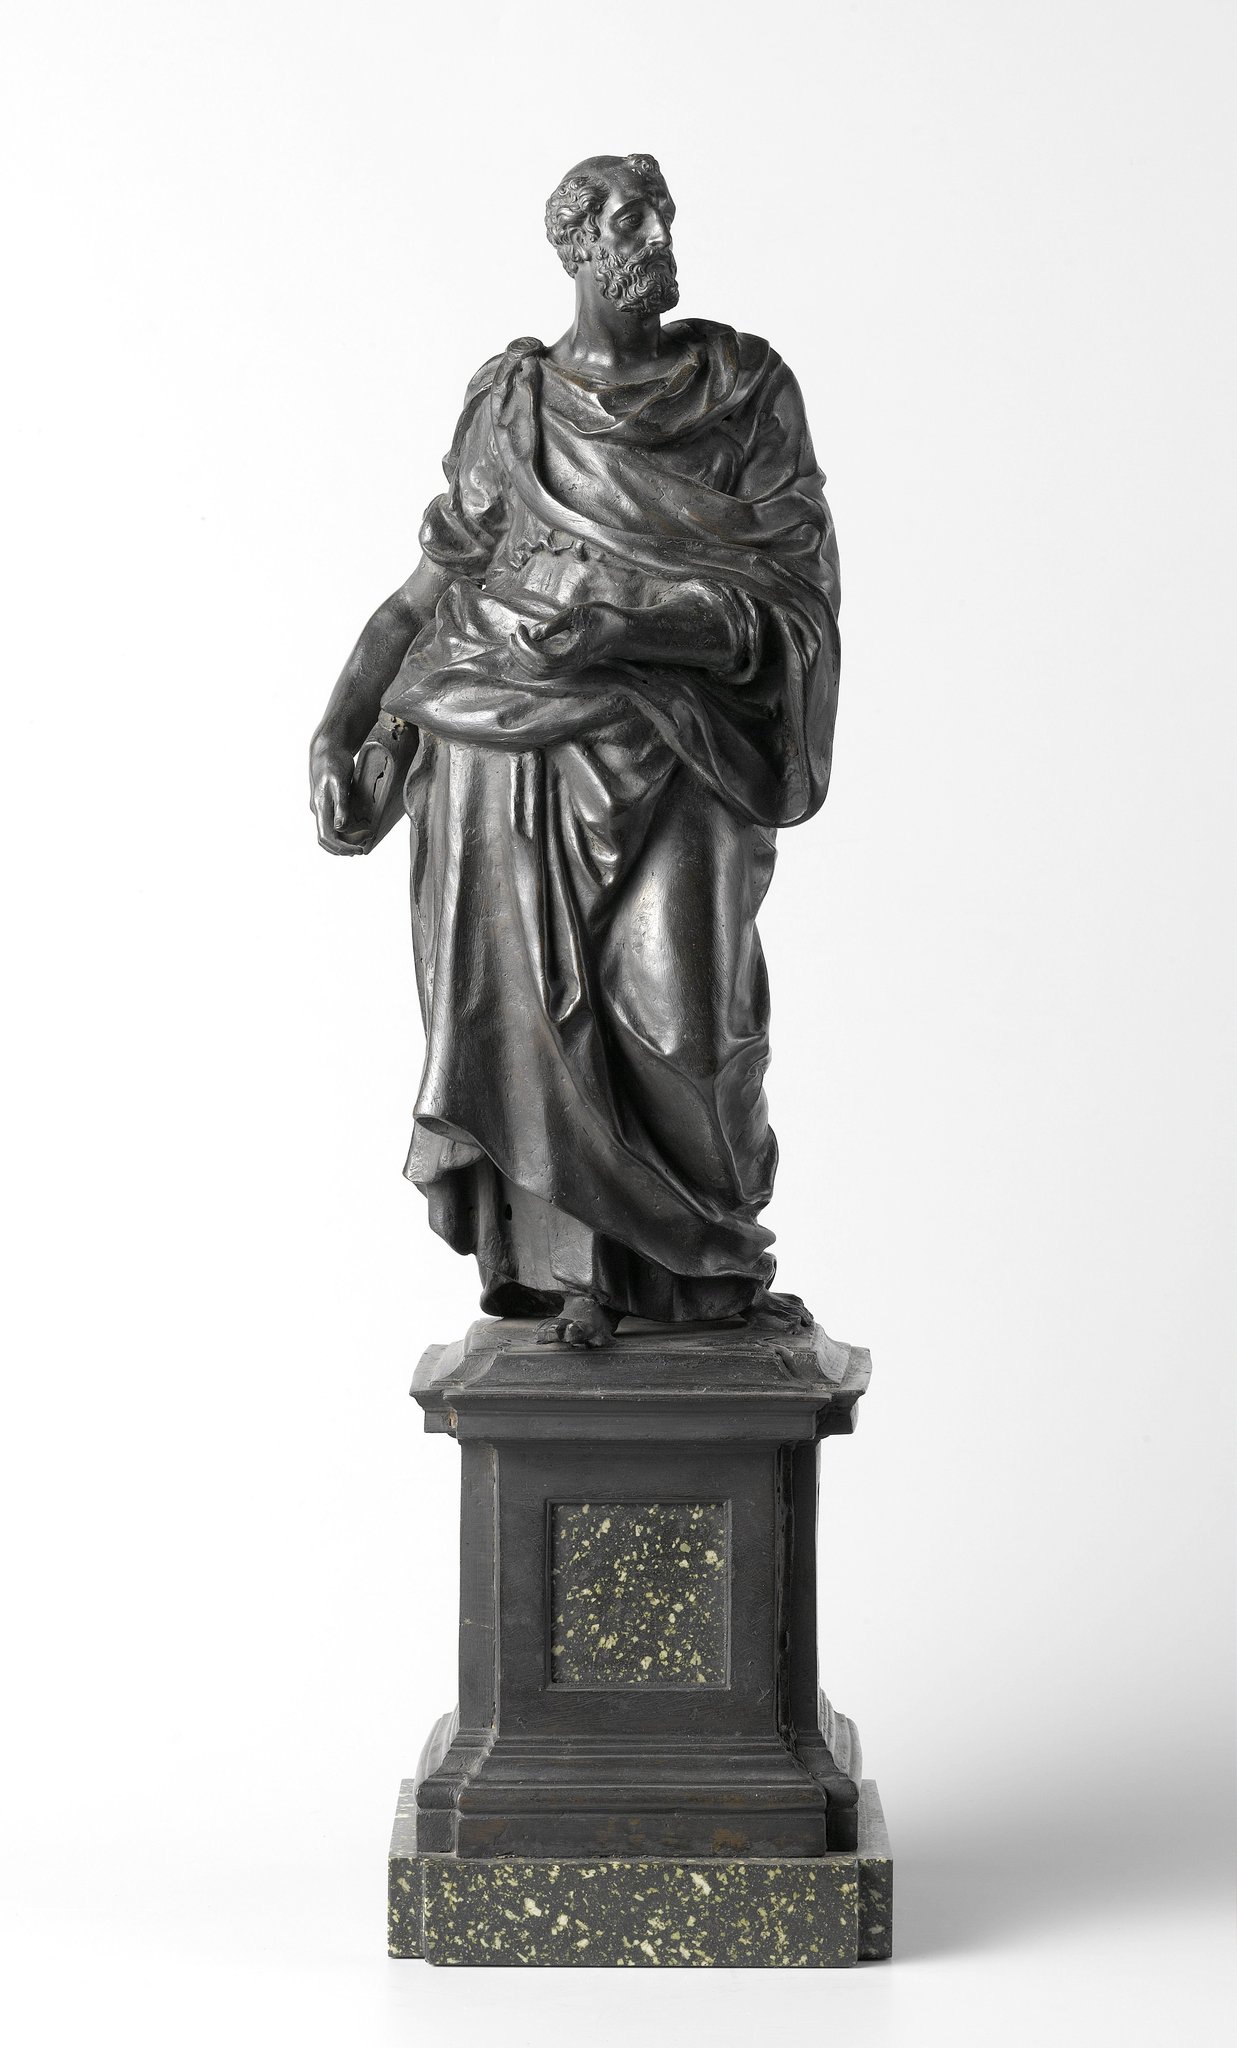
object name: sculpture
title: Petrus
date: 1600-1650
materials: bronze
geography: rome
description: Peter and Paul. Bronze, green and white mottled marble. Rome (?), c. 1600 - 1640.